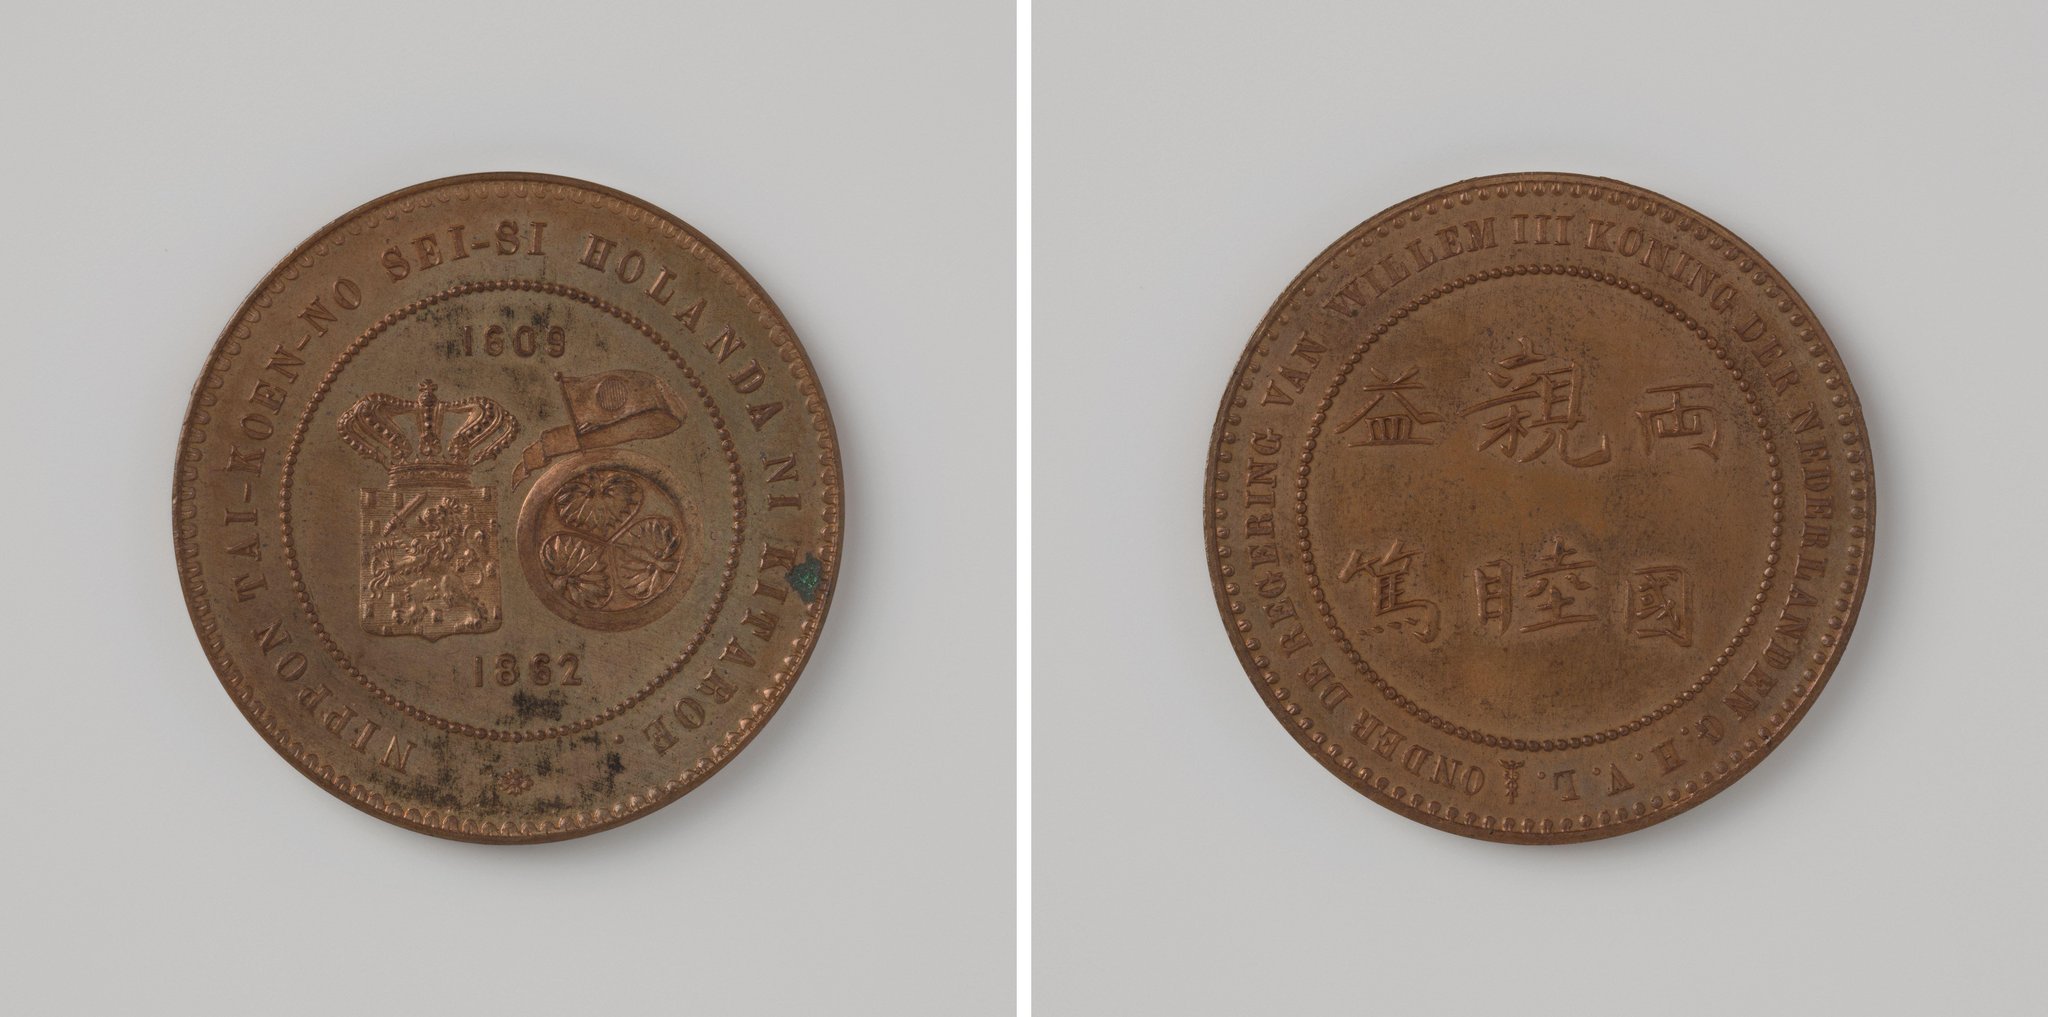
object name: history medal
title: Bezoek van het eerste Japanse gezantschap aan ´s Rijks Munt te Utrecht 1862, met muntteken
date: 1862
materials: bronze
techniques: striking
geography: utrecht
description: Bronzen penning, op de voorzijde de wapens van Nederland en Japan met de jaartallen 1609 en 1862, met omschrift, op de keerzijde zes Japanse karakters met omschrift waatussen een mercuriusstaf.